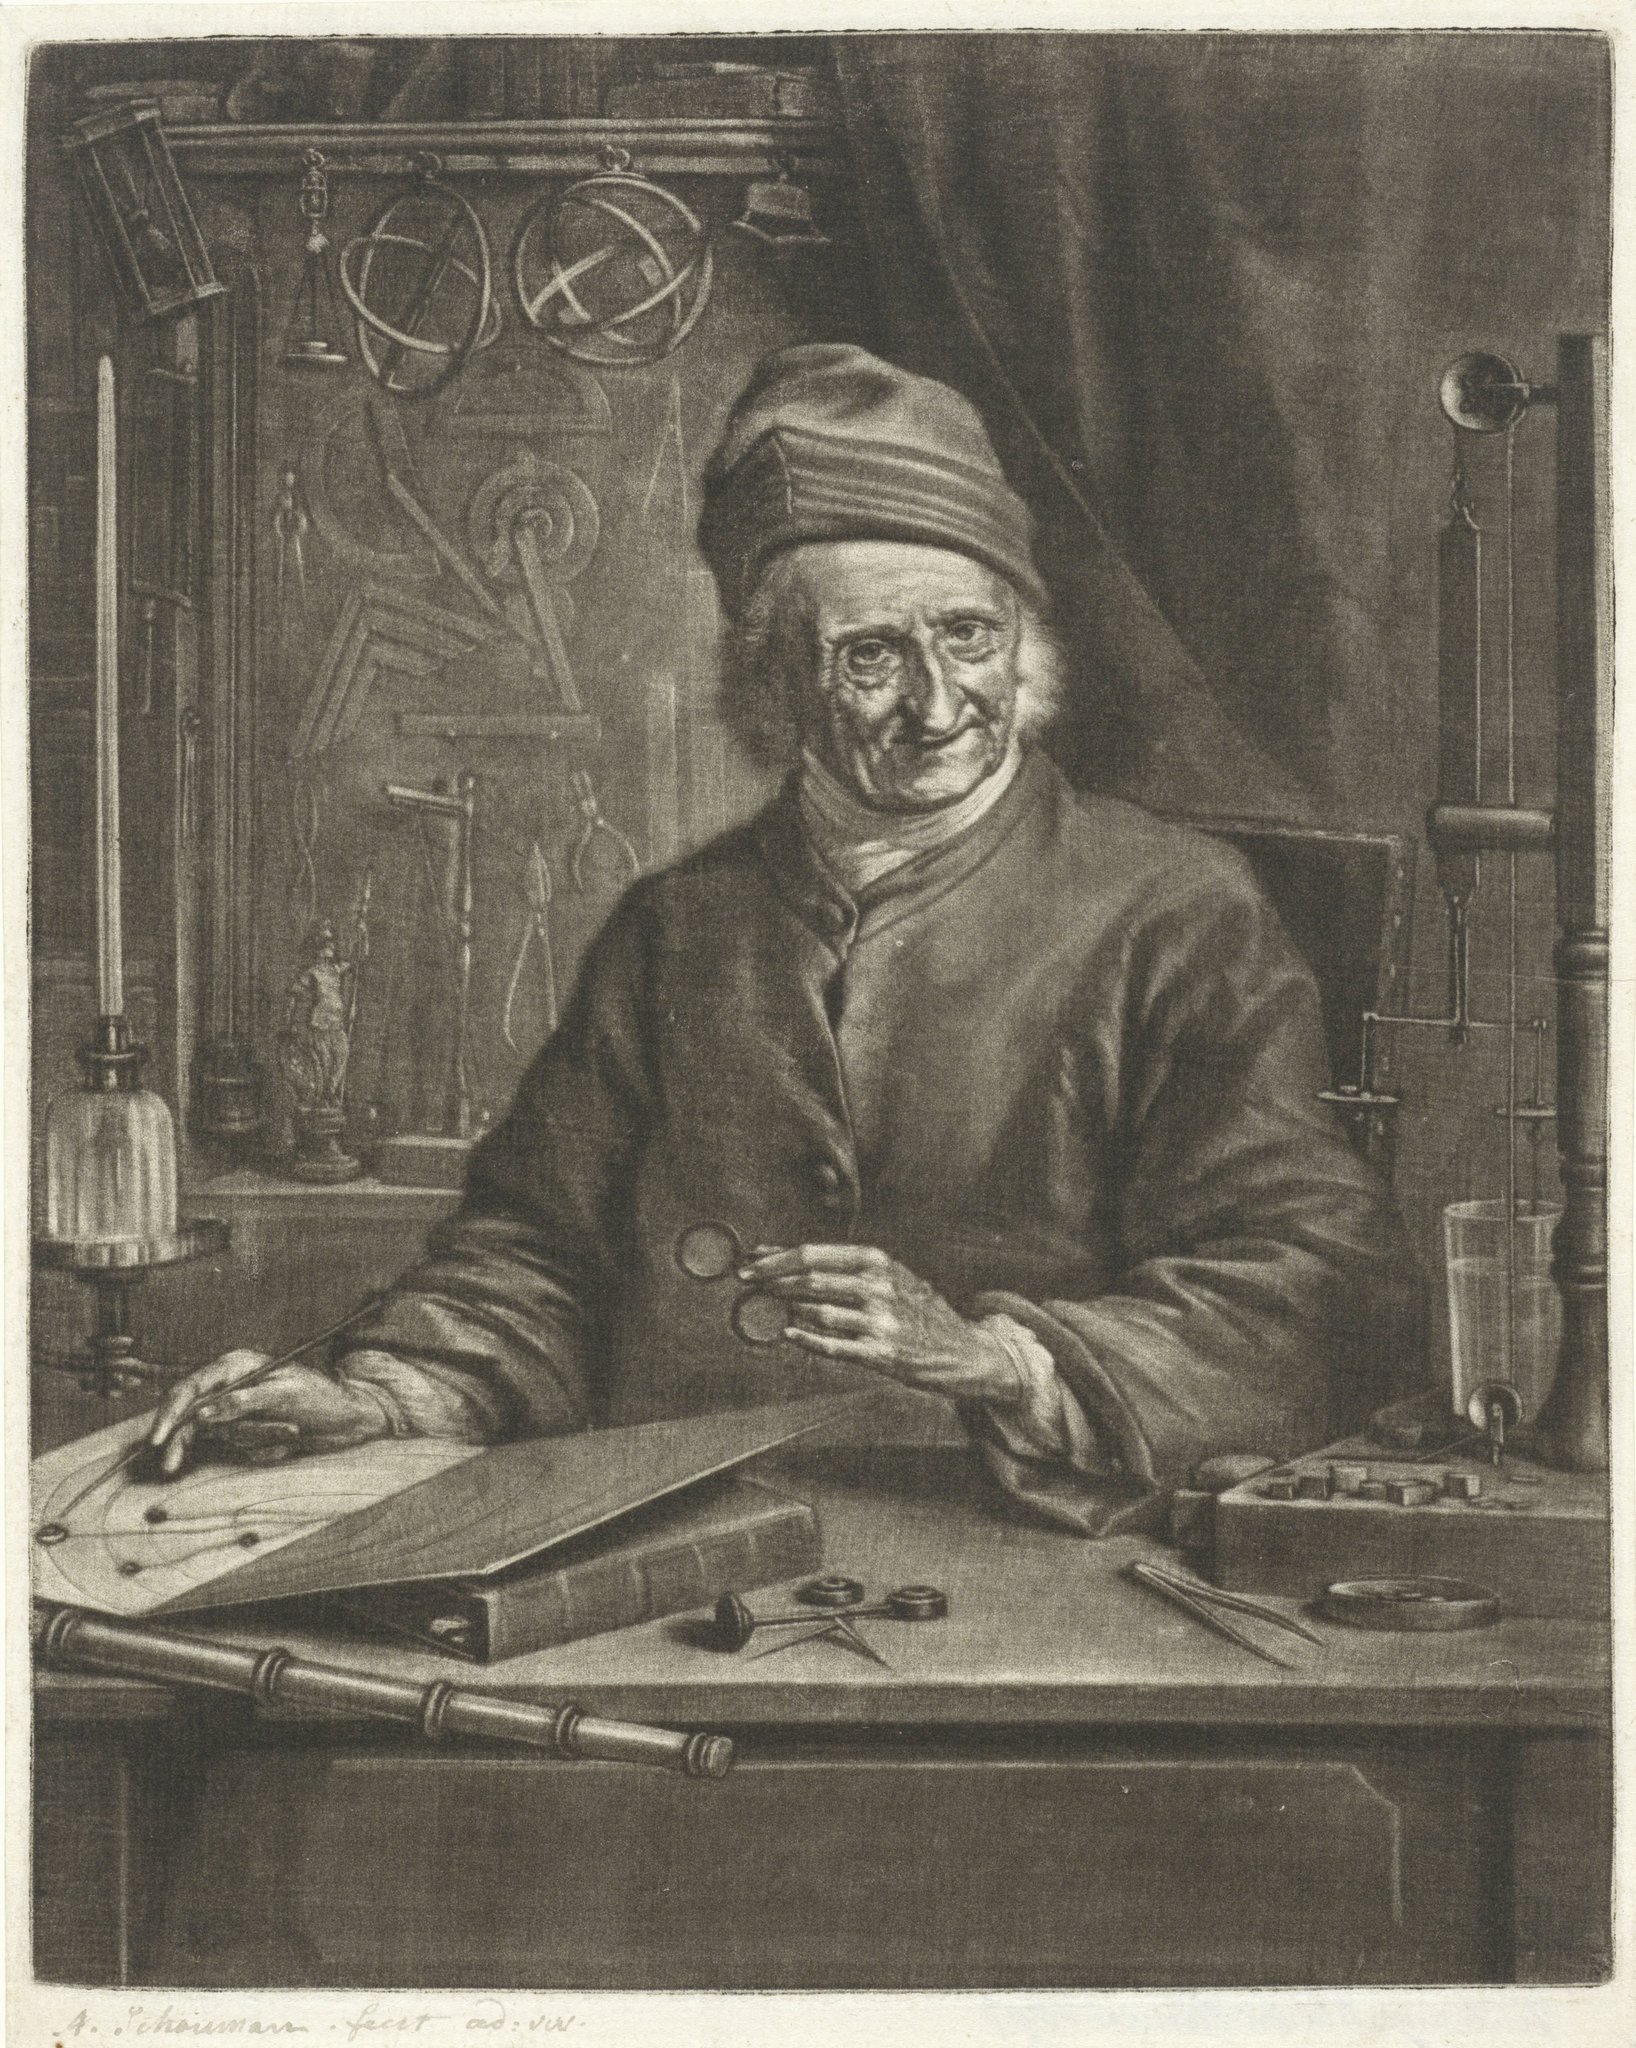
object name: print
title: Portret van Arnold Marcel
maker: aert schouman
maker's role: draughtsman, painter, print maker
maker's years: 1710-1792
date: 1748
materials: paper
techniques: mezzotint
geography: the hague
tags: physicist, instrument maker, measuring-instruments, spectacle-maker, optician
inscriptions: collector's mark: Lugt 2228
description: De wiskundige, natuurkundige en maker van vergrootglazen Arnold Marcel. Hij zit in zijn werkplaats, omringd met verschillende mathematische instrumenten.